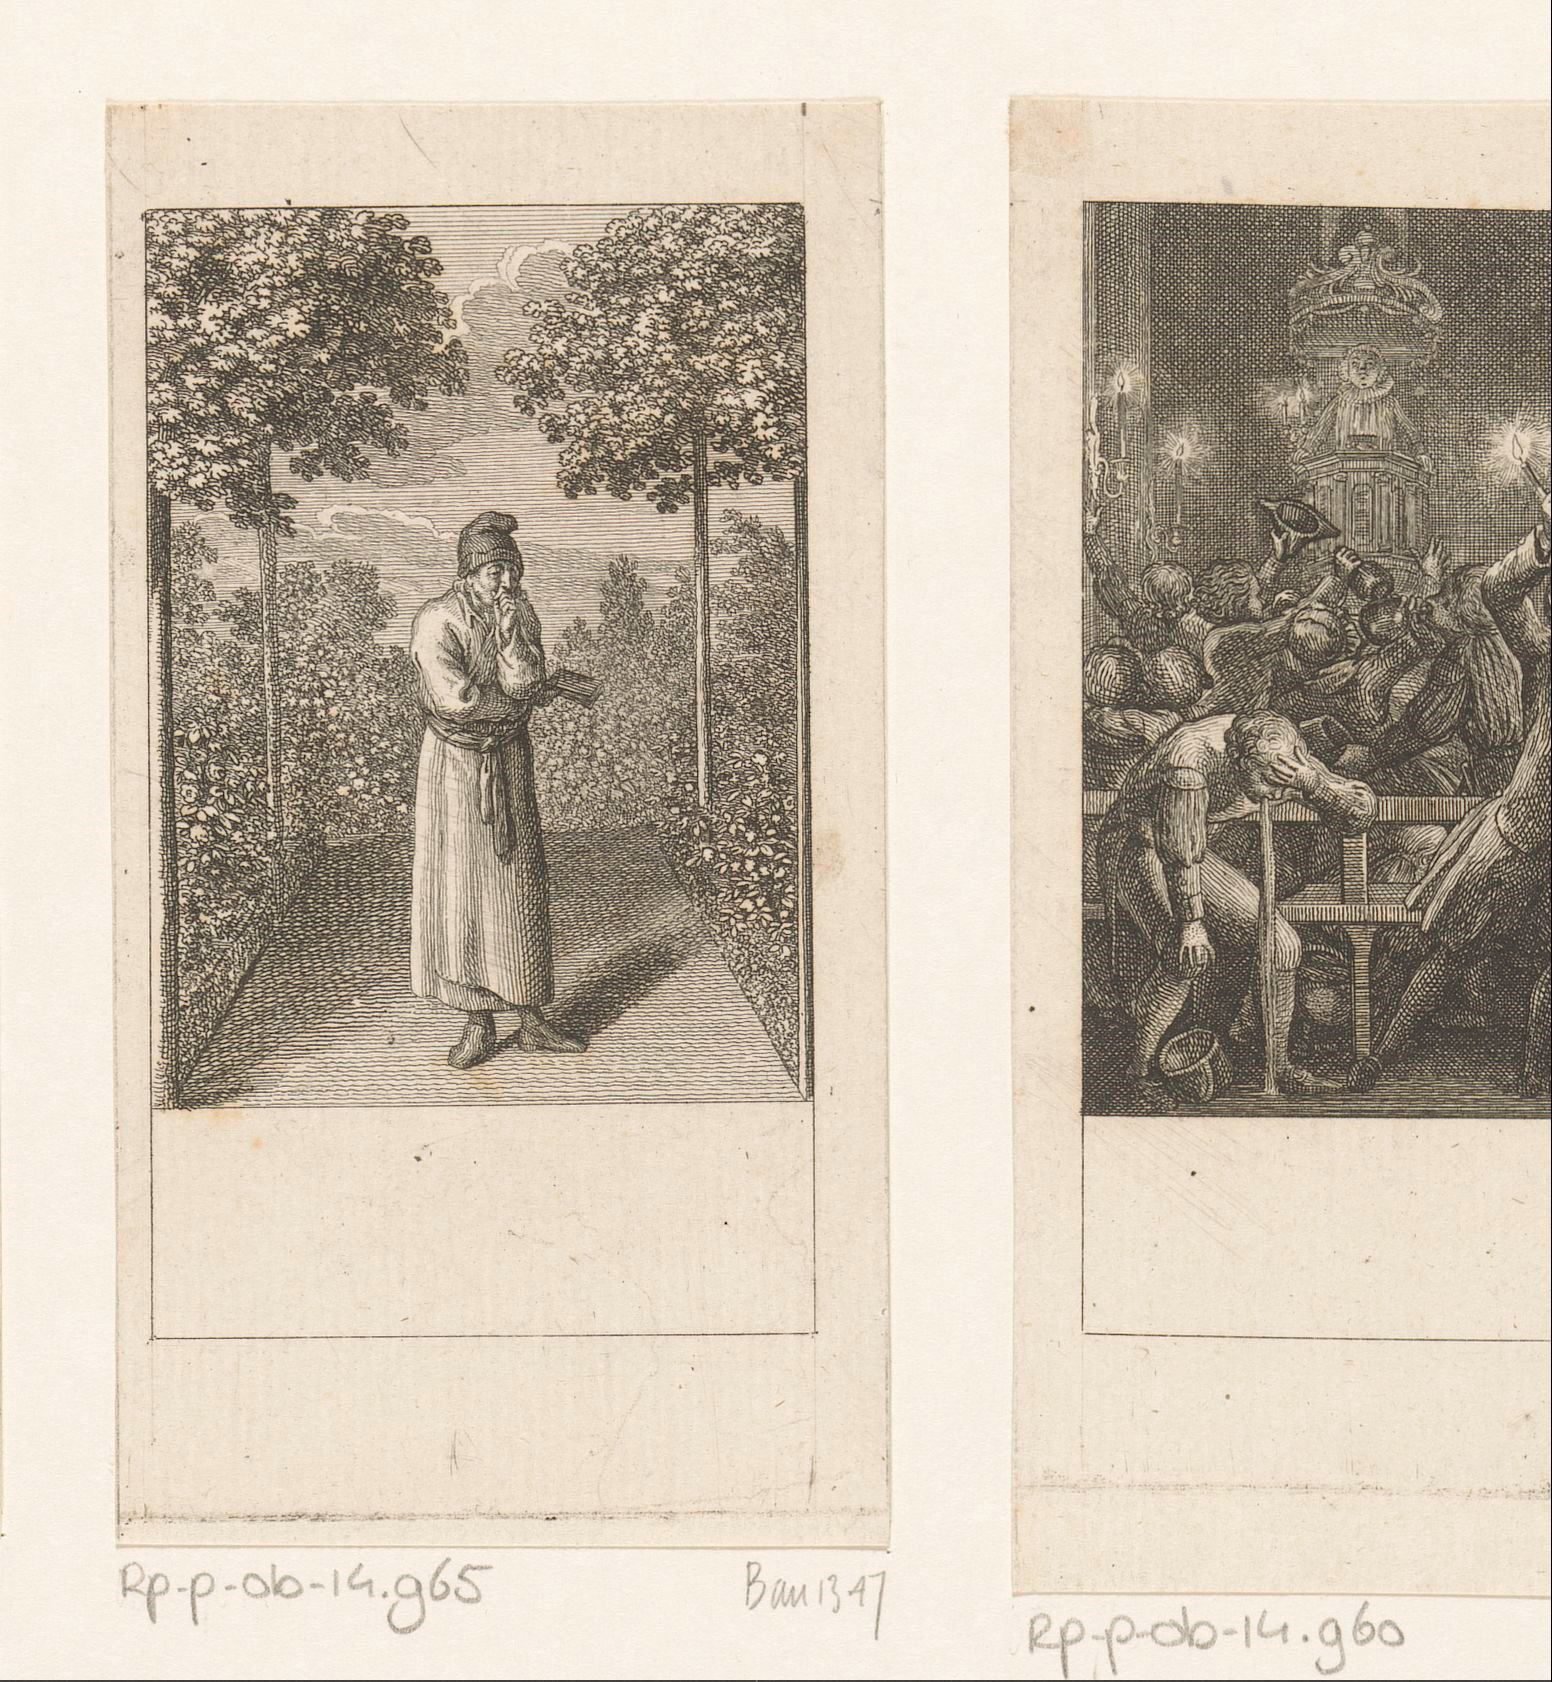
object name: print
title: Overpeinzende man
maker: daniel nikolaus chodowiecki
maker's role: draughtsman, print maker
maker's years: 1726-1801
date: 1788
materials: paper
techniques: etching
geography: berlin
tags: thinking, thought, reflection; 'pensiero' (ripa), letter, envelope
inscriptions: collector's mark: Lugt 2228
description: Vervaardigd voor een serie over Duitse rages. Latere staat gebruikt voor: Berliner genealogischen Calender auf das Jahr 1789. [Berlijn]: s.n., [1788].